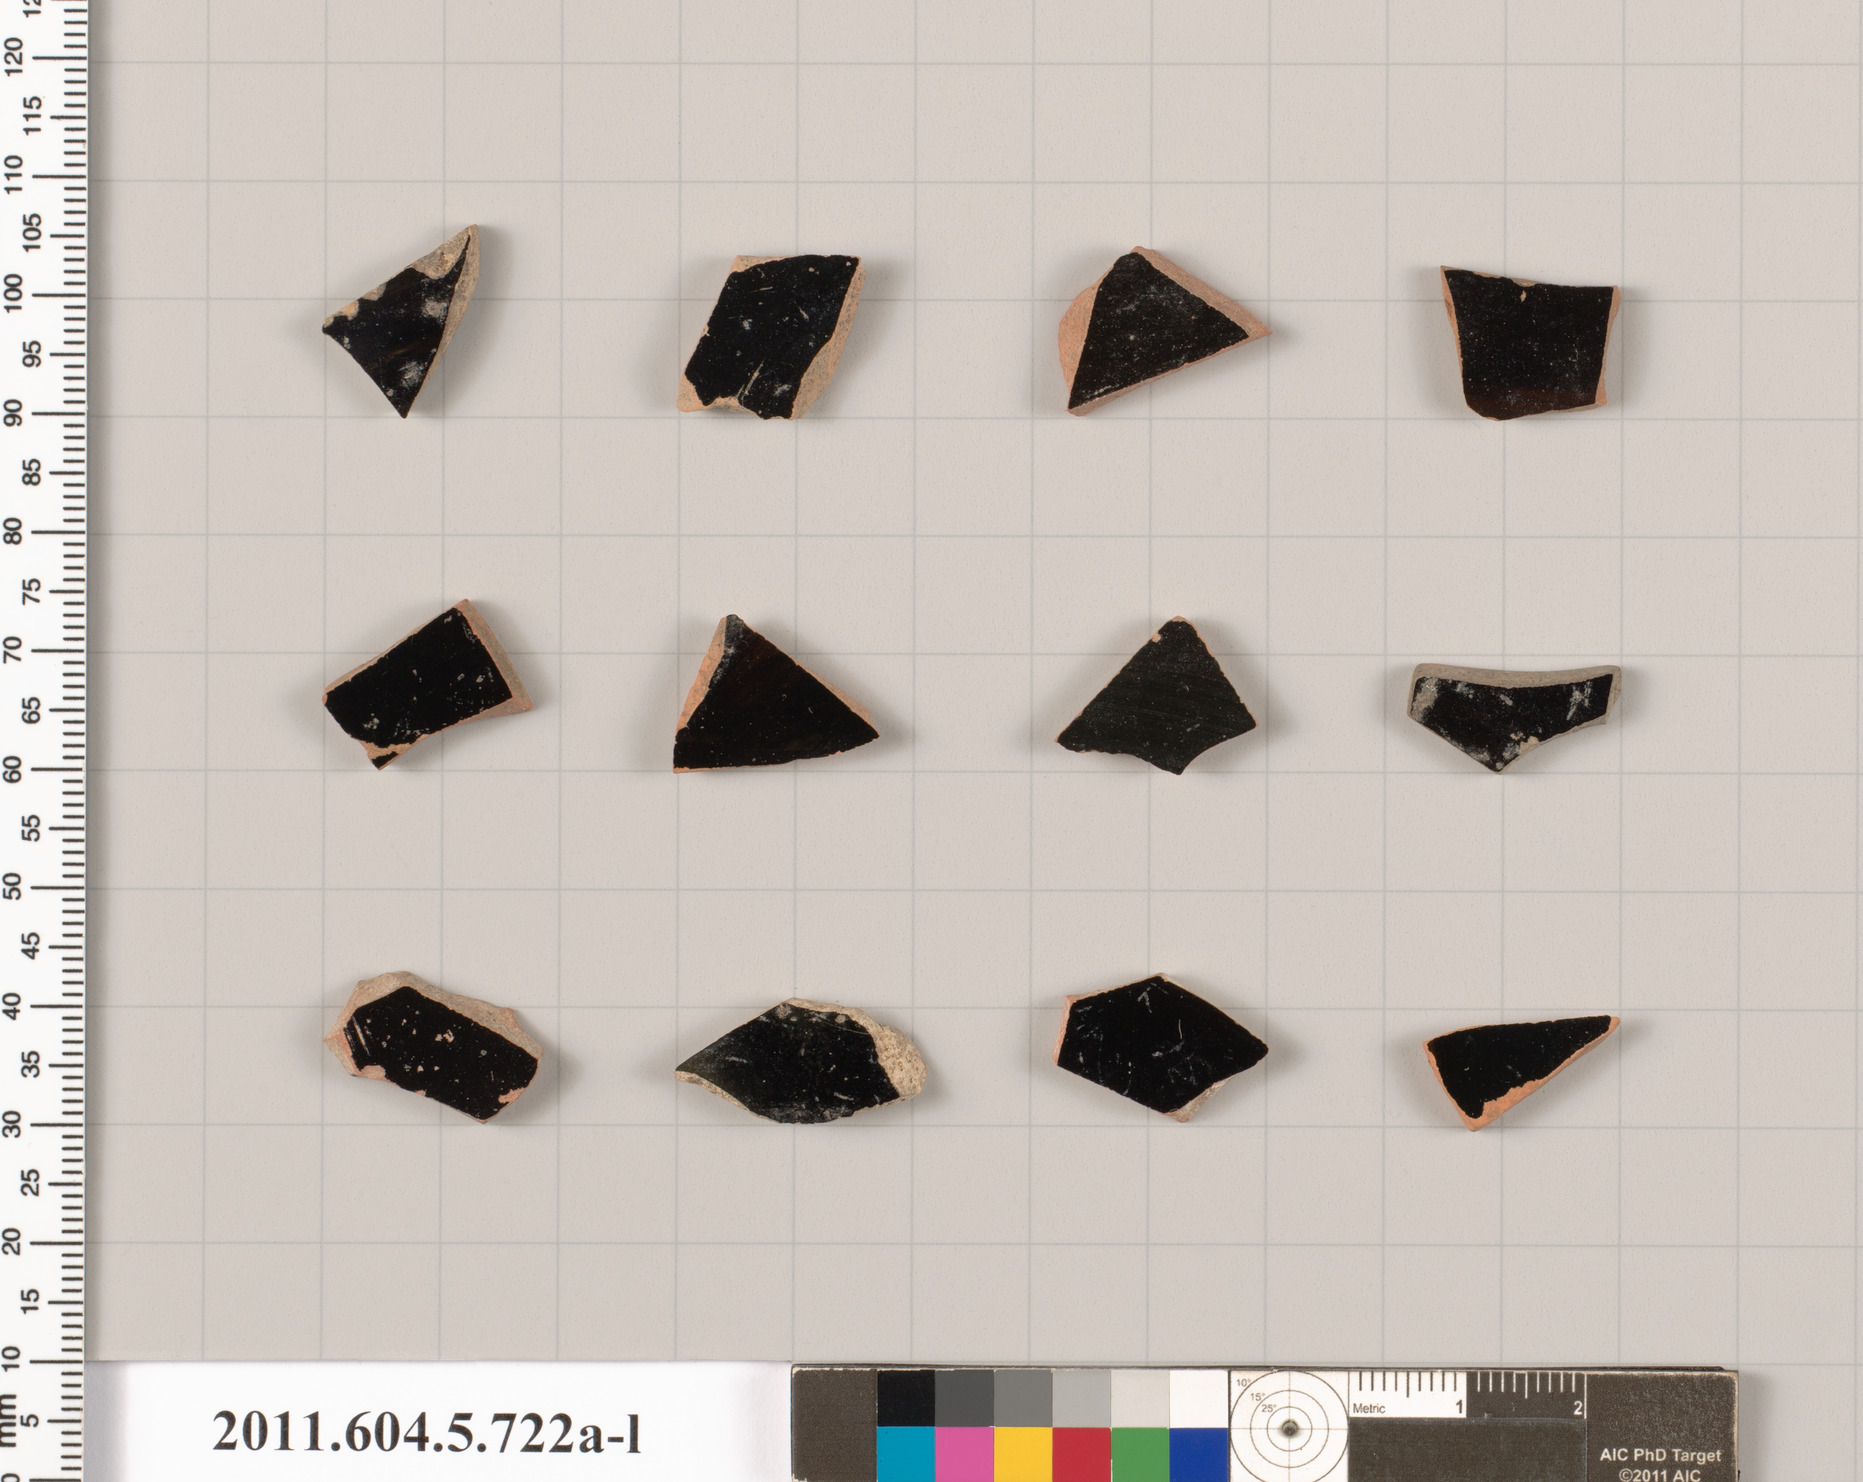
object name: kylix fragment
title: Terracotta fragments of kylikes (drinking cups)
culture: greek, attic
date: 600-401 BCE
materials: terracotta